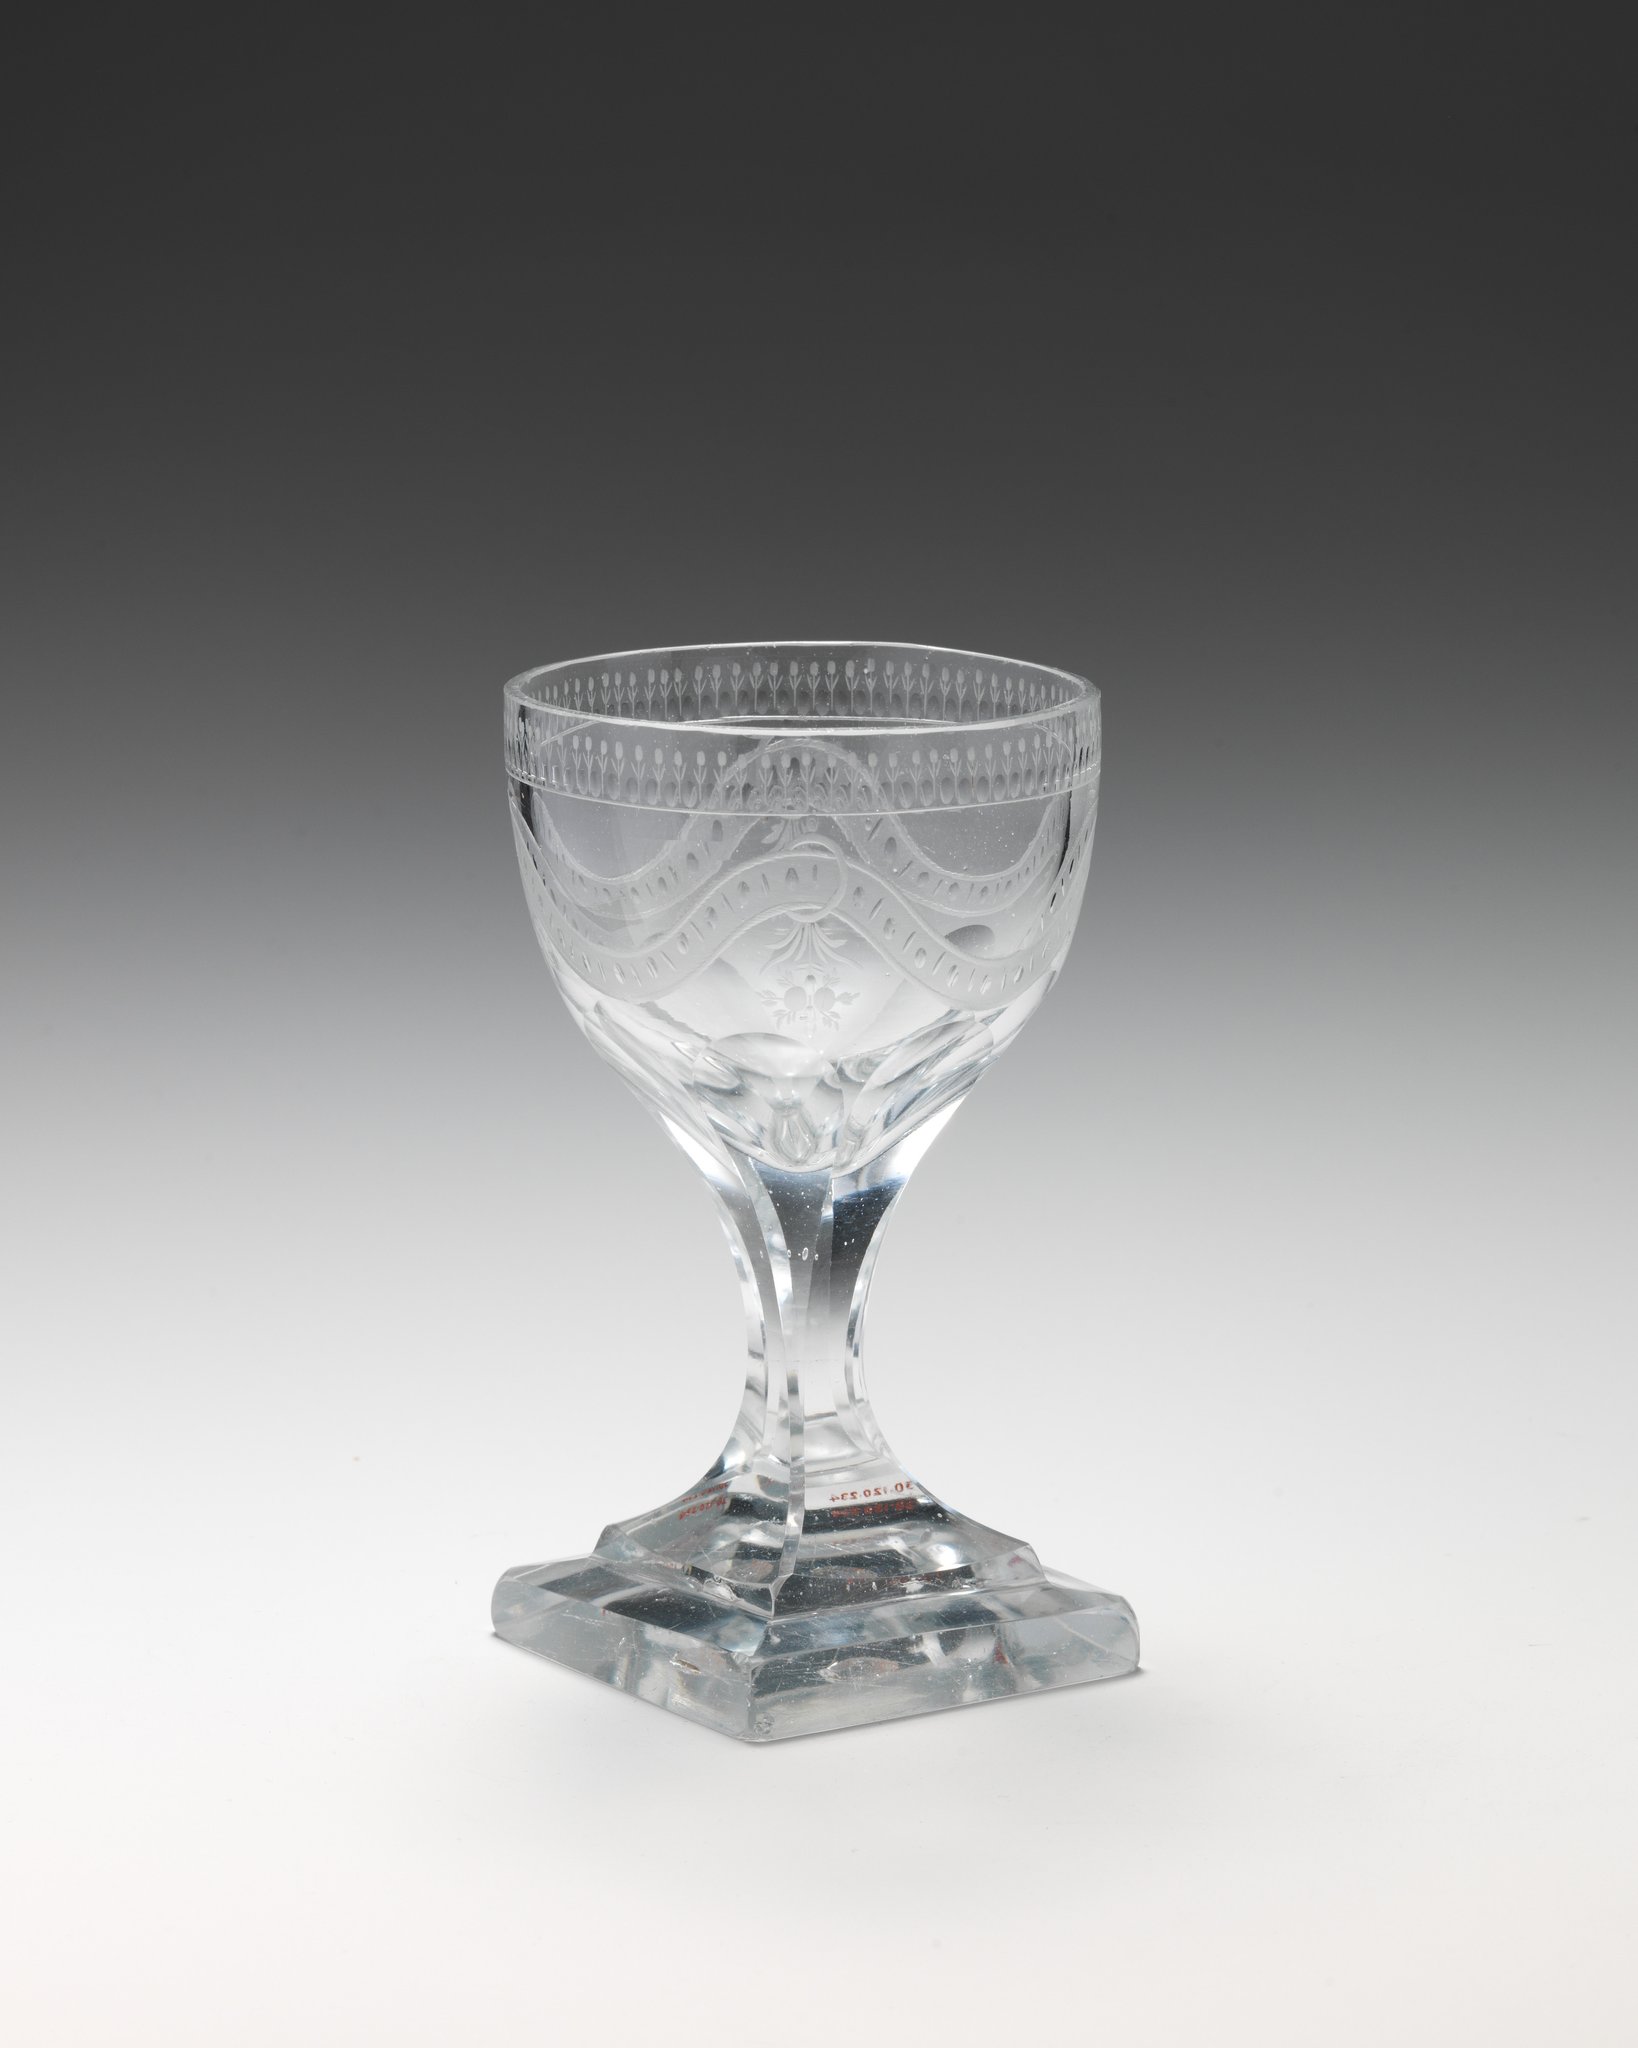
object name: wineglass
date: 1701-1900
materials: glass